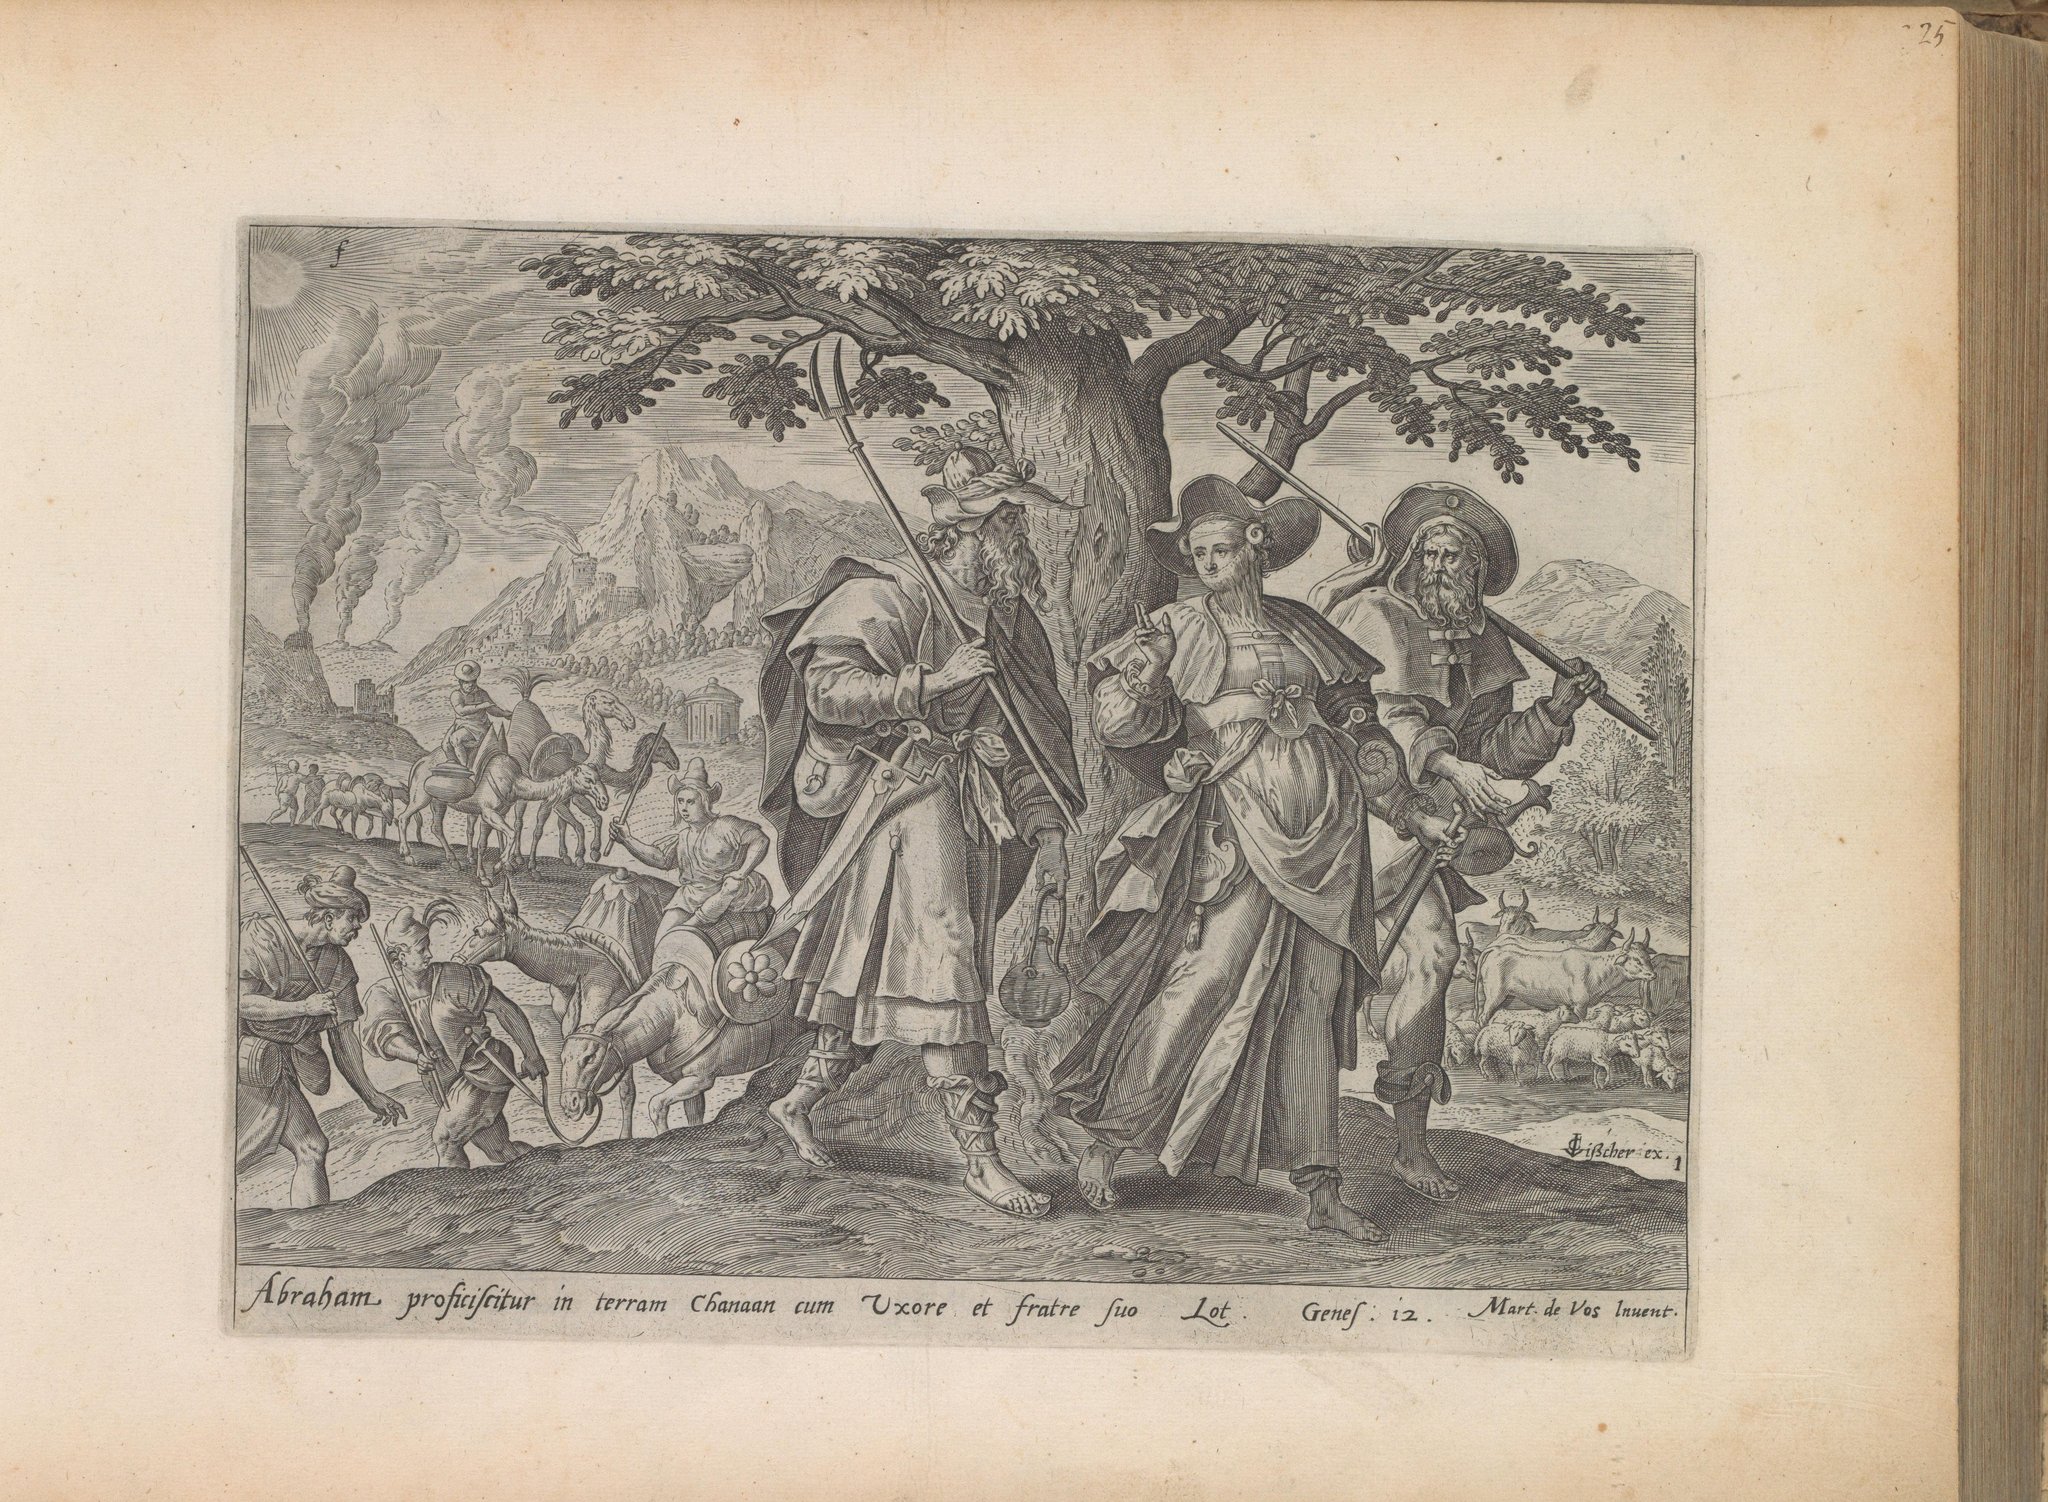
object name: album leaf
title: Geschiedenis van Abraham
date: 1585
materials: paper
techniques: engraving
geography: amsterdam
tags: abraham starts out for the land of canaan with sarah, lot and his belongings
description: Abraham vertrekt met zijn familie, tot slaaf gemaakte mannen en vrouwen en vee naar Kanaän. Op de voorgrond in het landschap lopen Abraham, zijn vrouw Sara en zijn neef Lot. Onder de voorstelling een verwijzing in het Latijn naar de Bijbeltekst in Gen. 12. Deze prent maakt deel uit van een album.